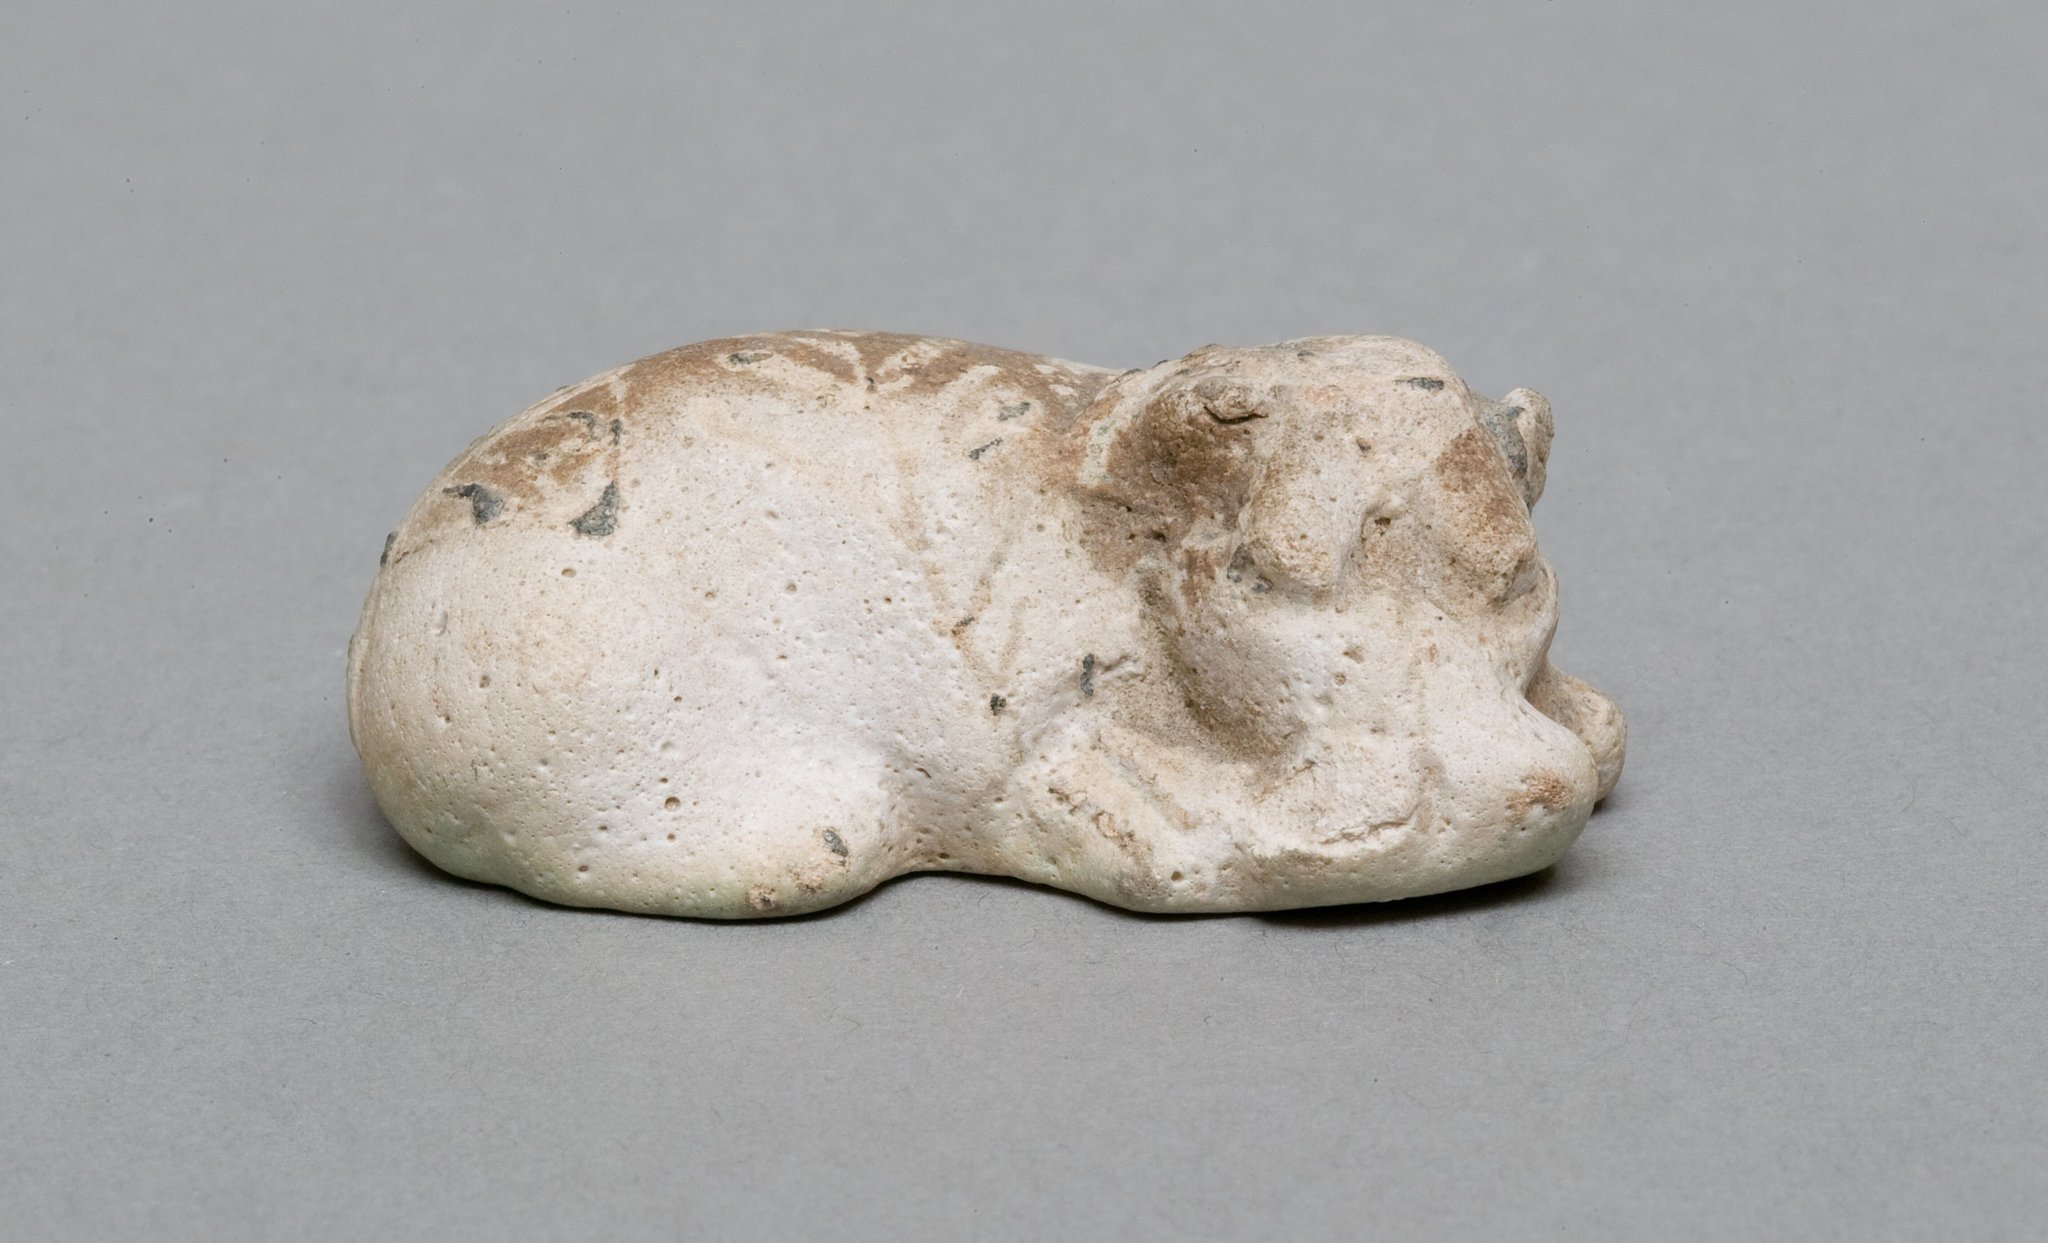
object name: figurine, hippopotamus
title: Hippopotamus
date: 1850-1640 BCE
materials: faience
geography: egypt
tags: hippos